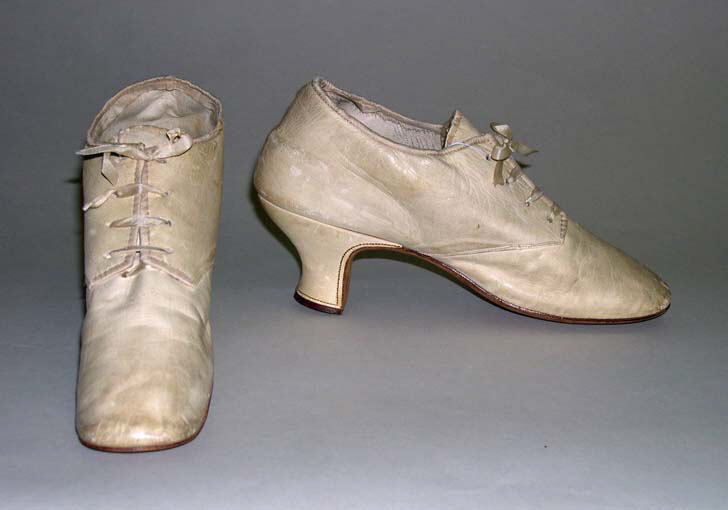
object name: wedding shoe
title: Wedding shoes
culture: american or european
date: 1875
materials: leather